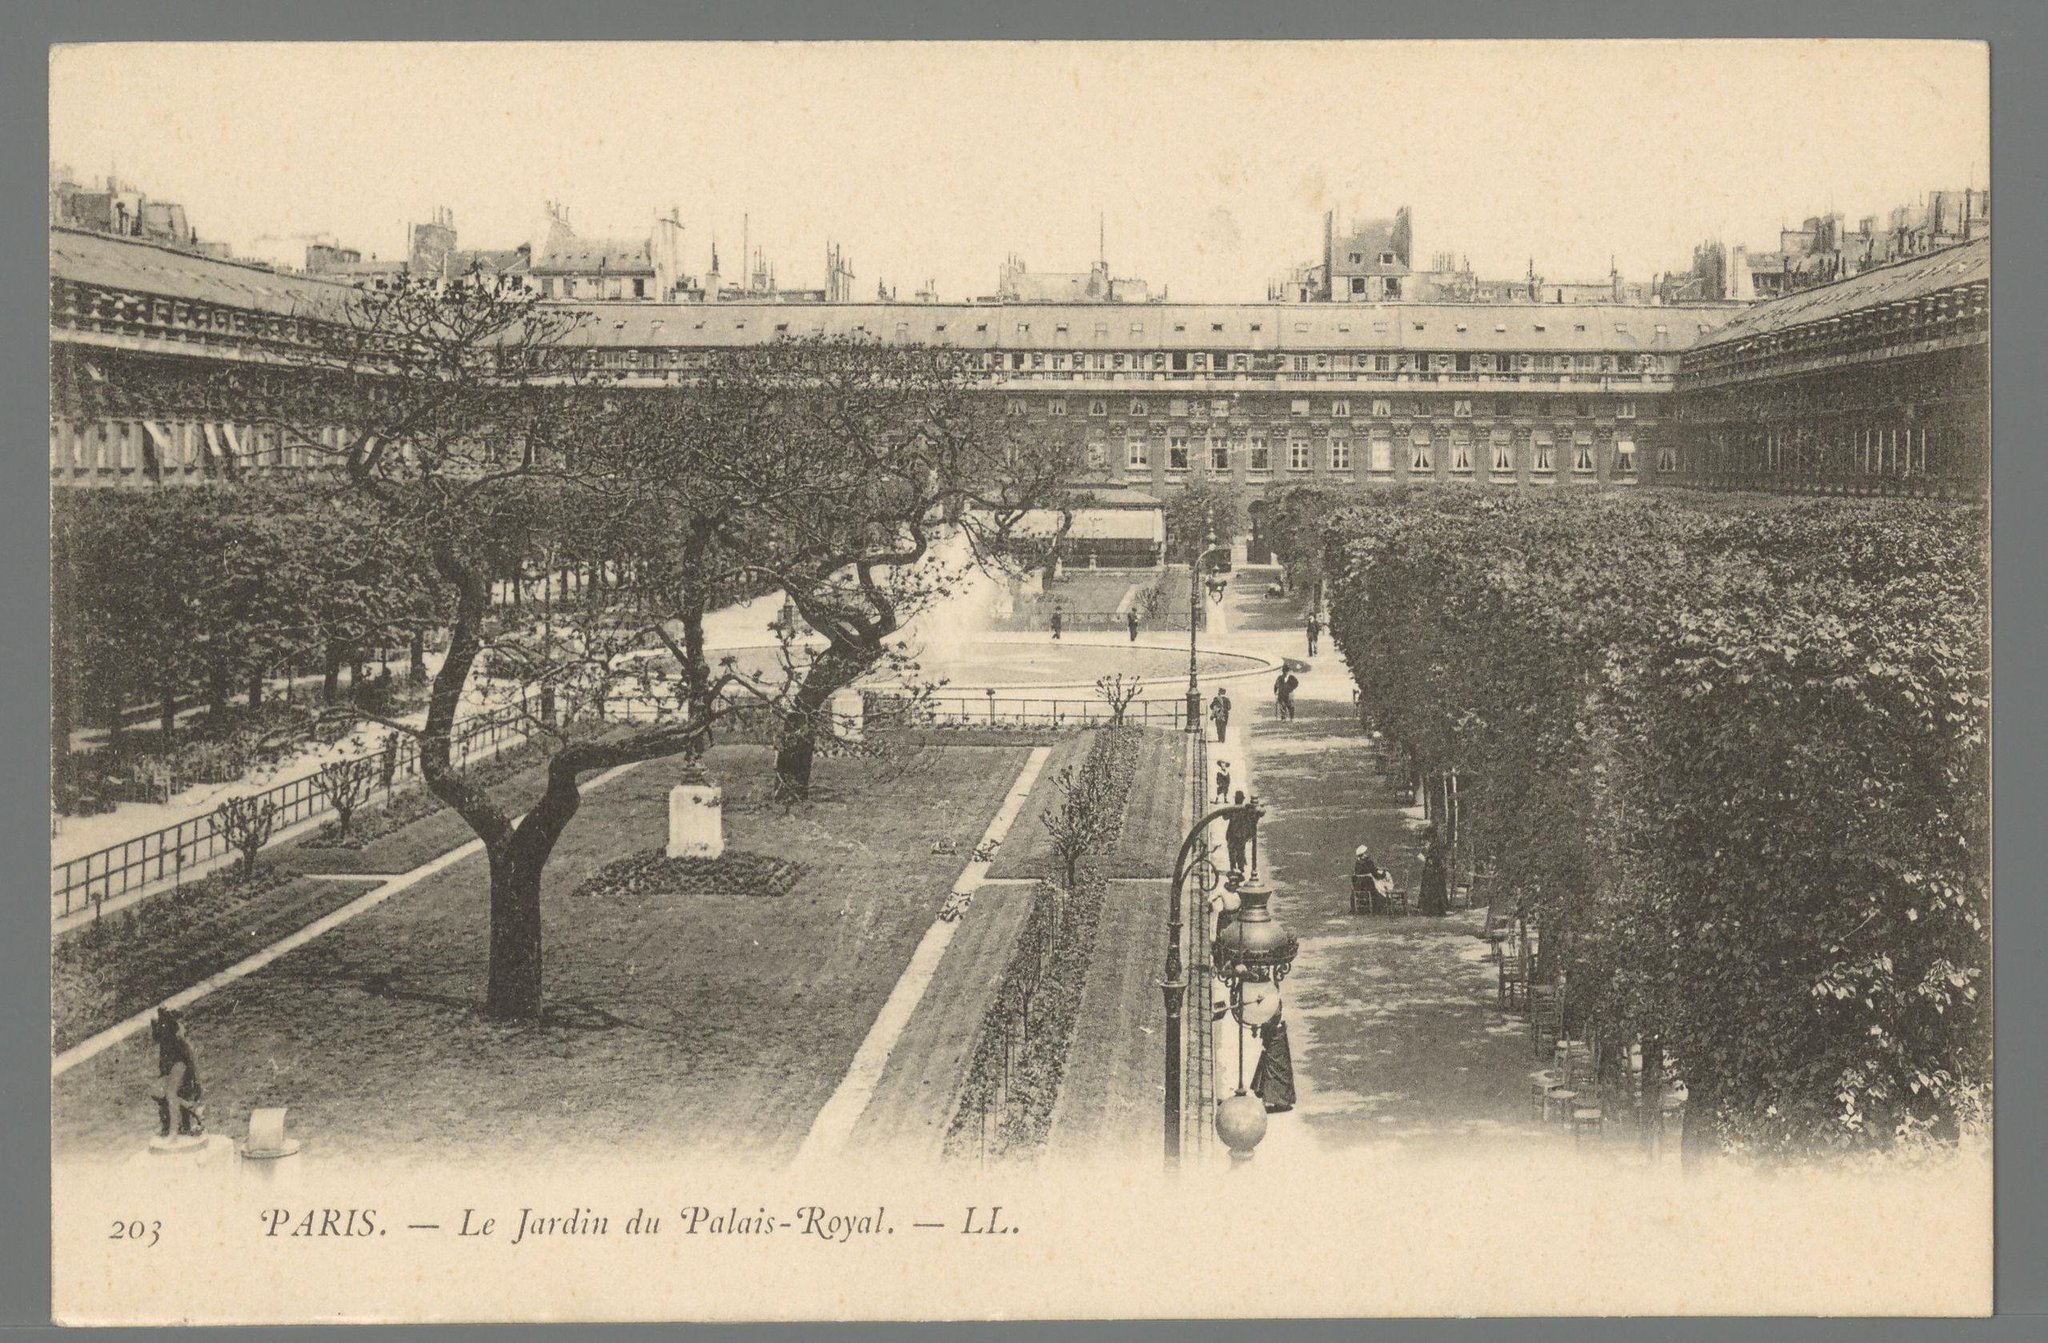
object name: photomechanical print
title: Paris. le Jardin du Palais-Royal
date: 1895-1904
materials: cardboard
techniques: photograph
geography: paris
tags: public gardens, park (+ city(-scape) with figures, staffage), palace